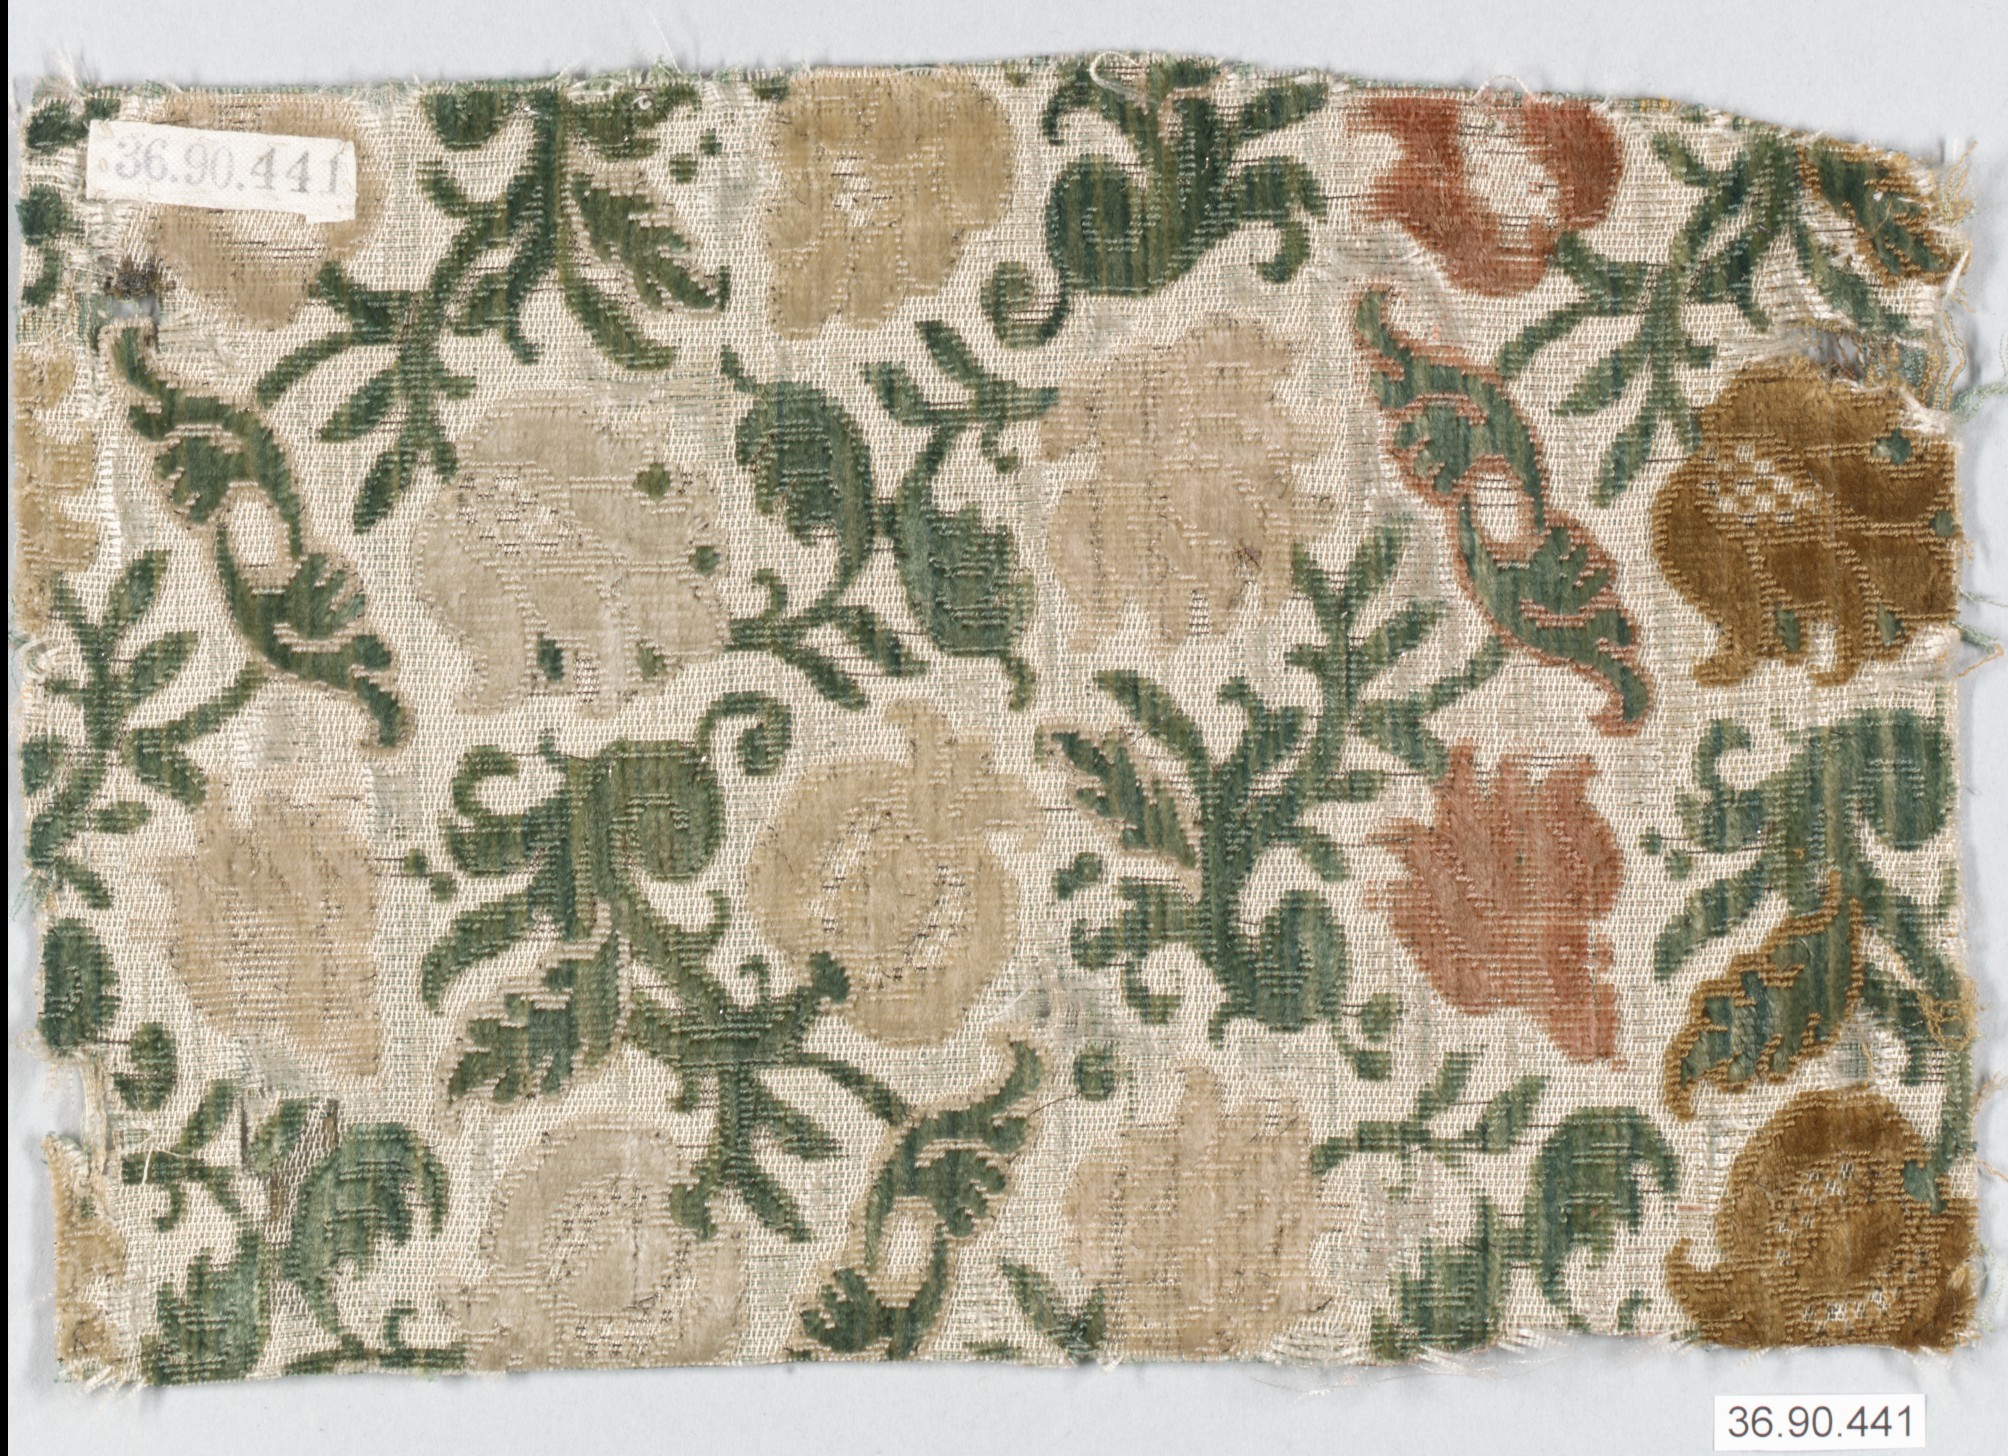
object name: piece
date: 1501-1700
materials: metal thread, silk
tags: flowers,leaves